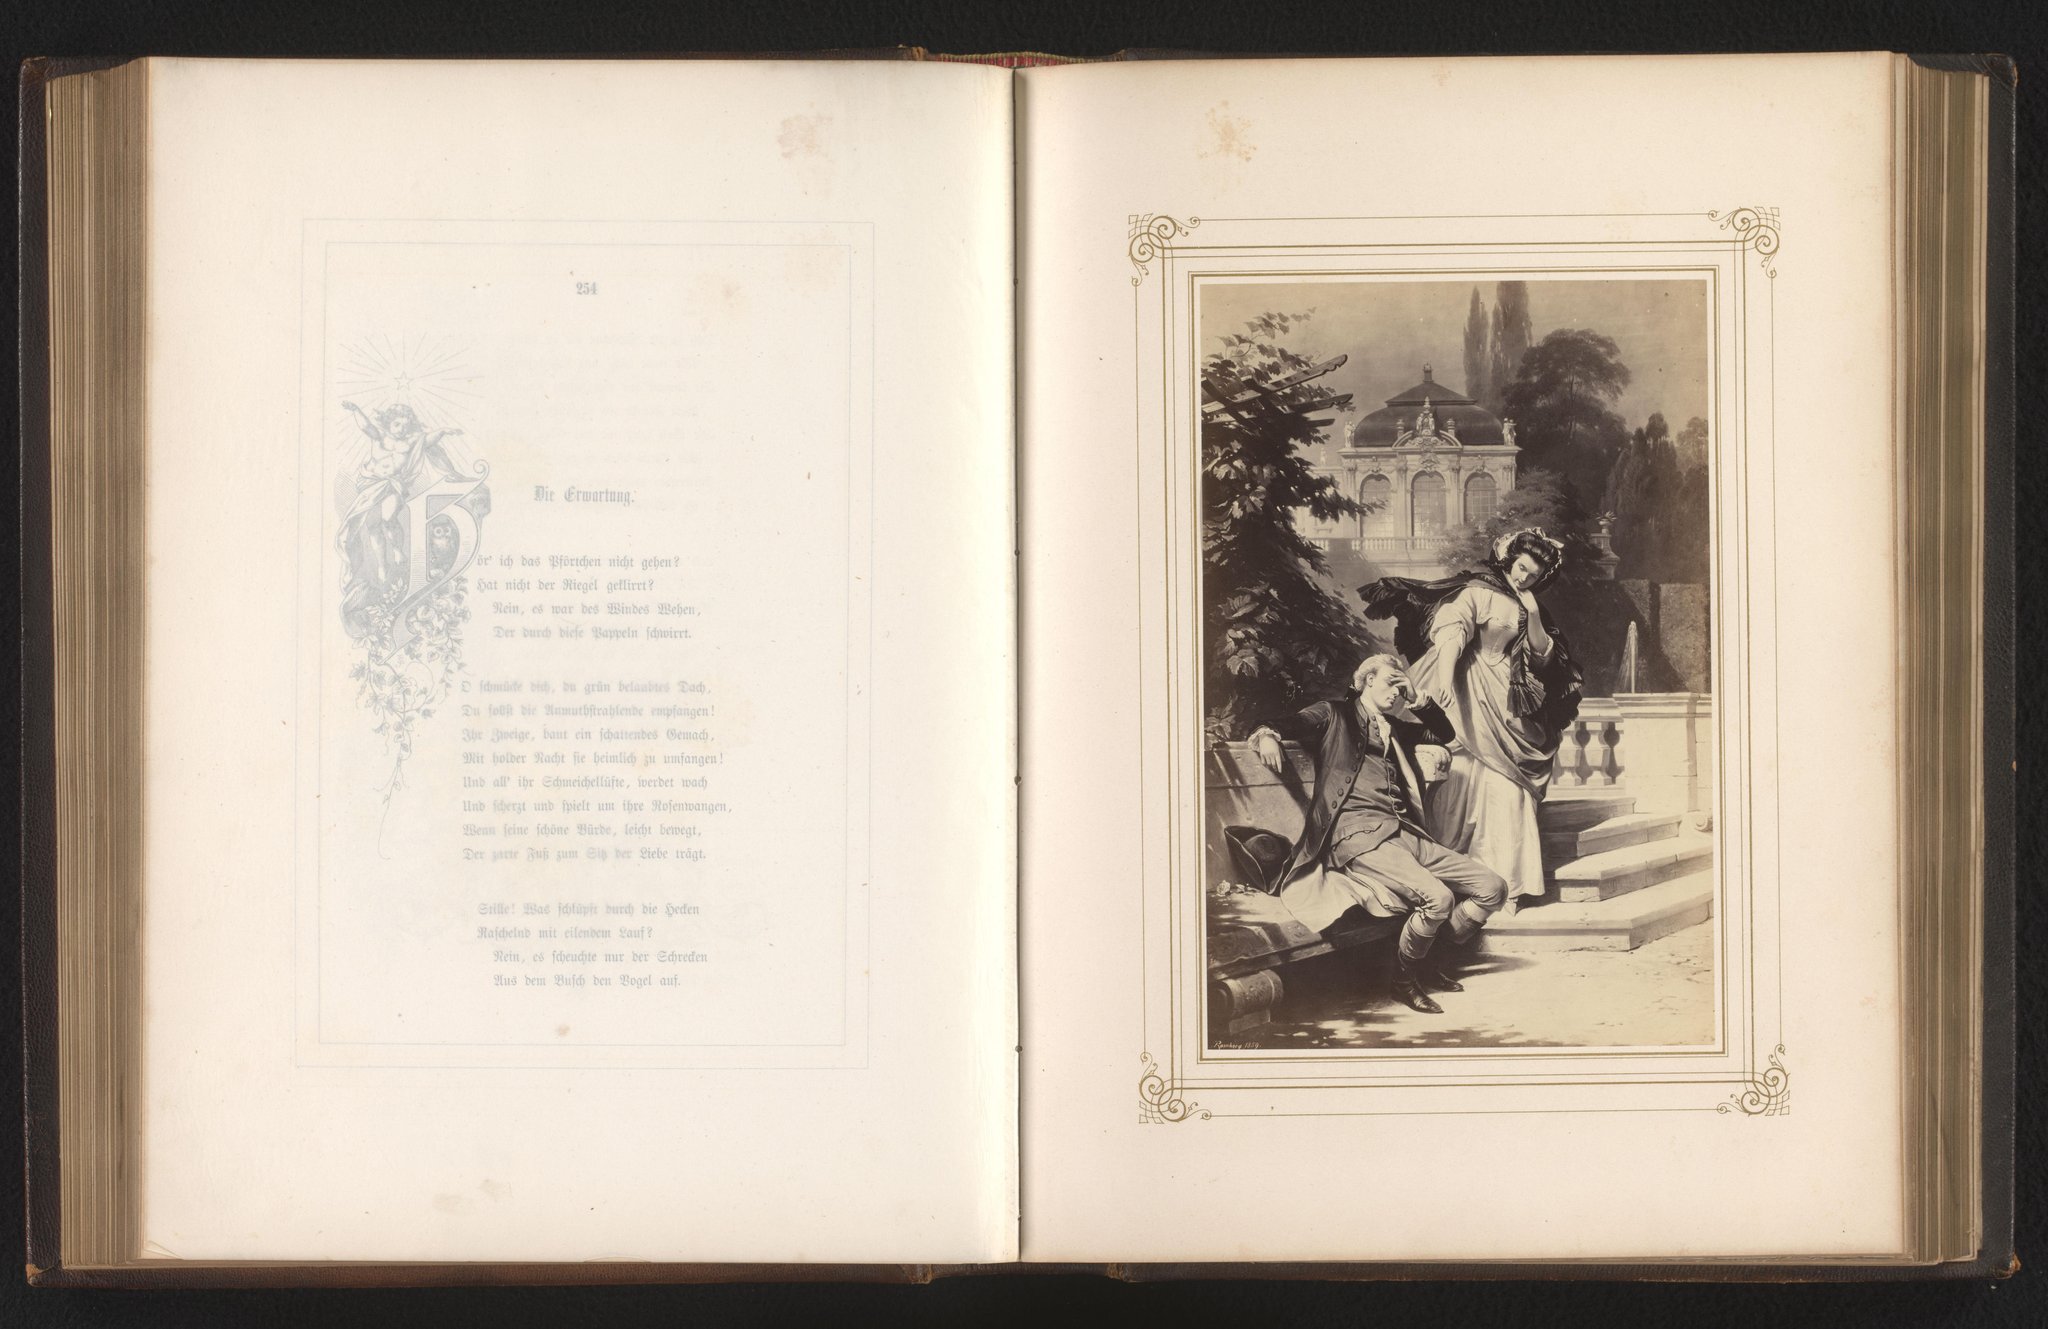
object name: photograph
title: Ramberg: Die Erwartung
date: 1859-1862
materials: paper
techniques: albumen print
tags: french or architectonic garden; formal garden, lovers' meeting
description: Foto op ongenummerde pagina na pagina 254.